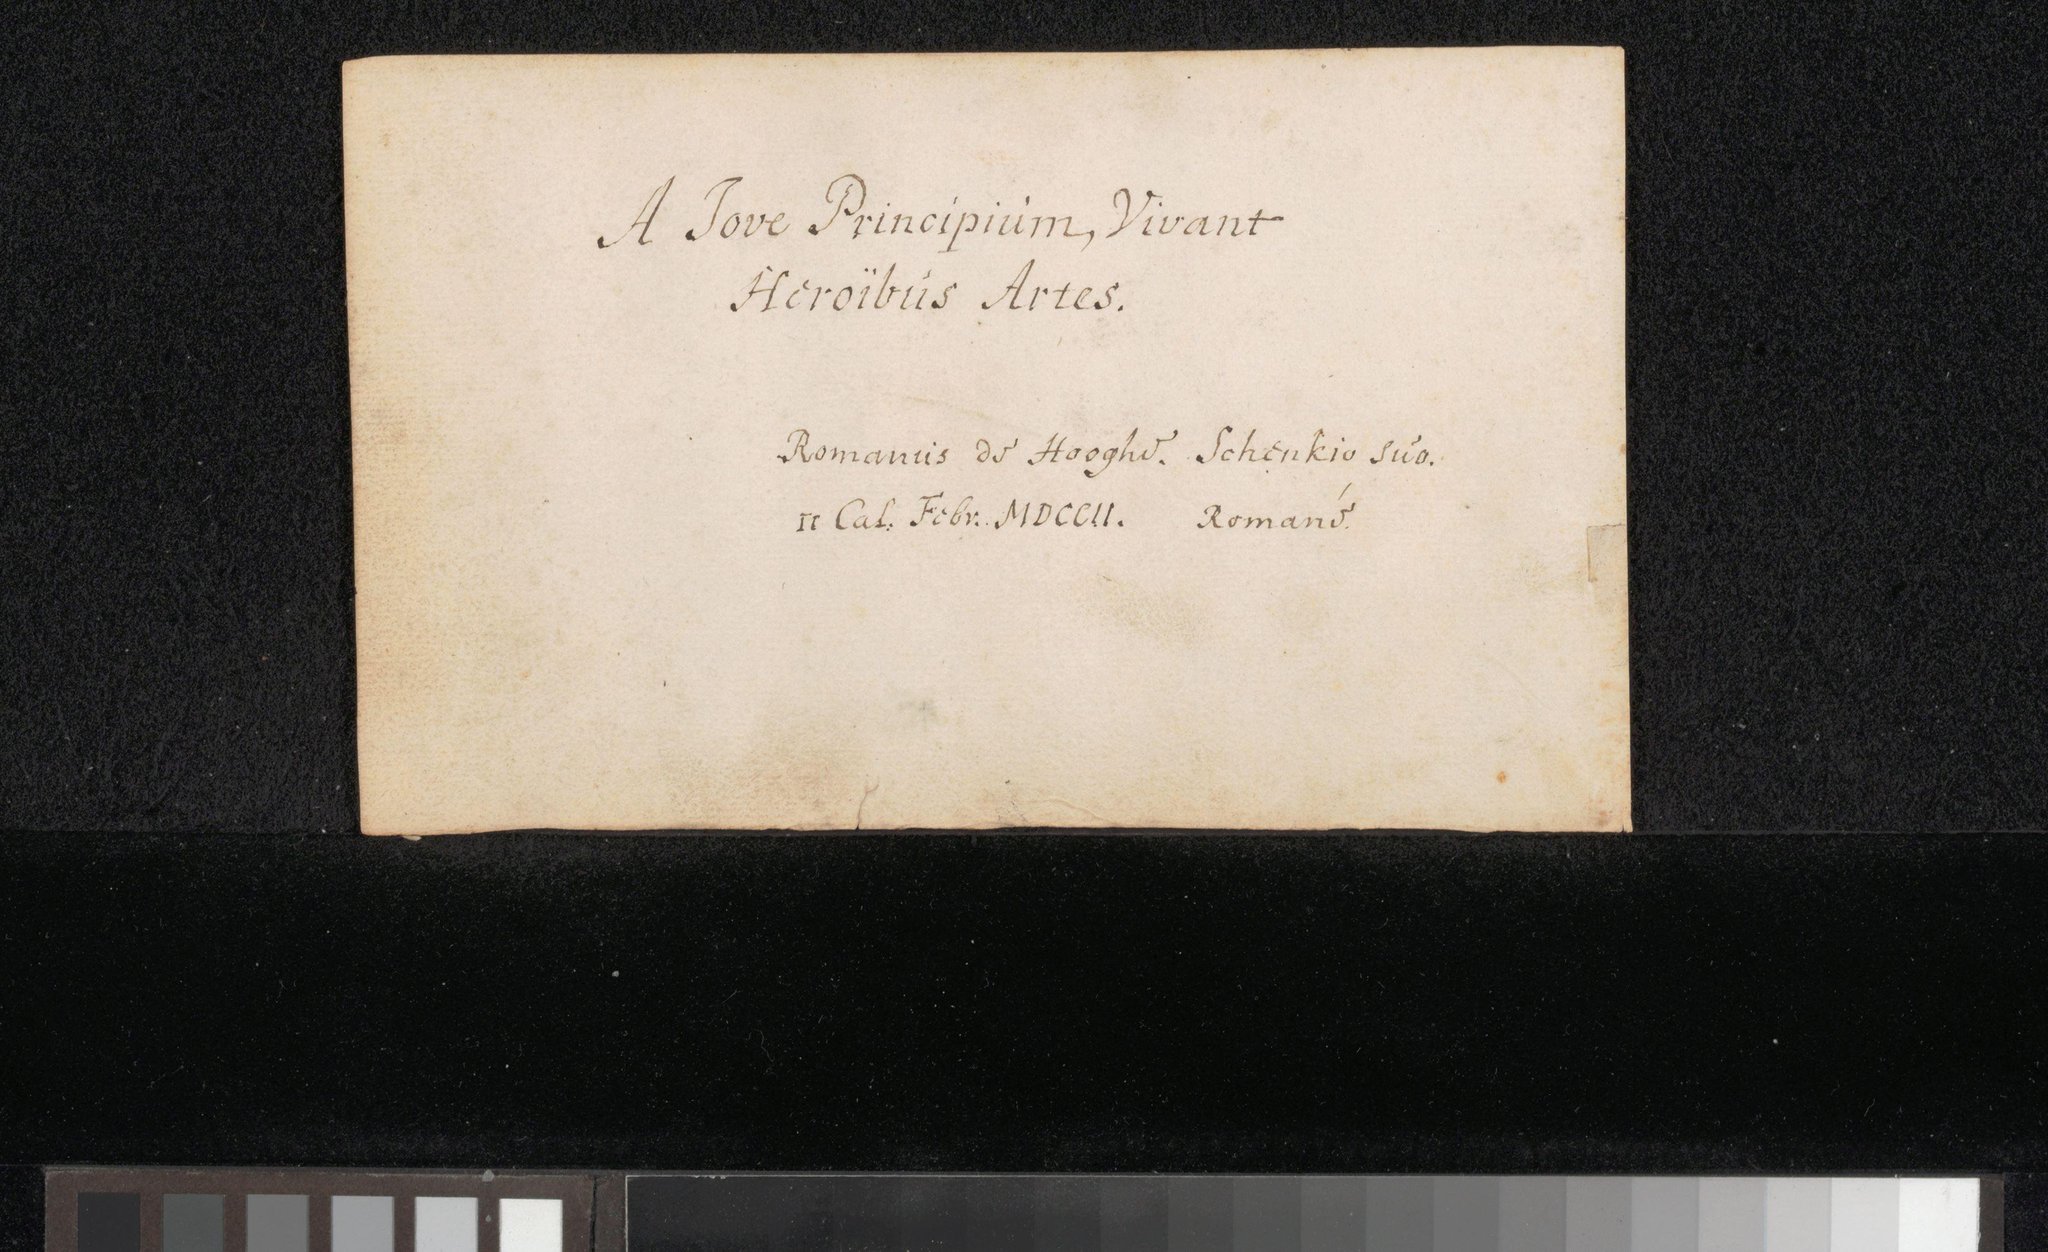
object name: letter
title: Brief aan anoniem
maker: romeyn de hooghe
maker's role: draughtsman, goldsmith, painter, print maker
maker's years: 1645-1708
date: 1702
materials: ink, paper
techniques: pen, writing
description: Vermoedelijk gericht aan een familielid. Verso aantekening gedateerd 1701.